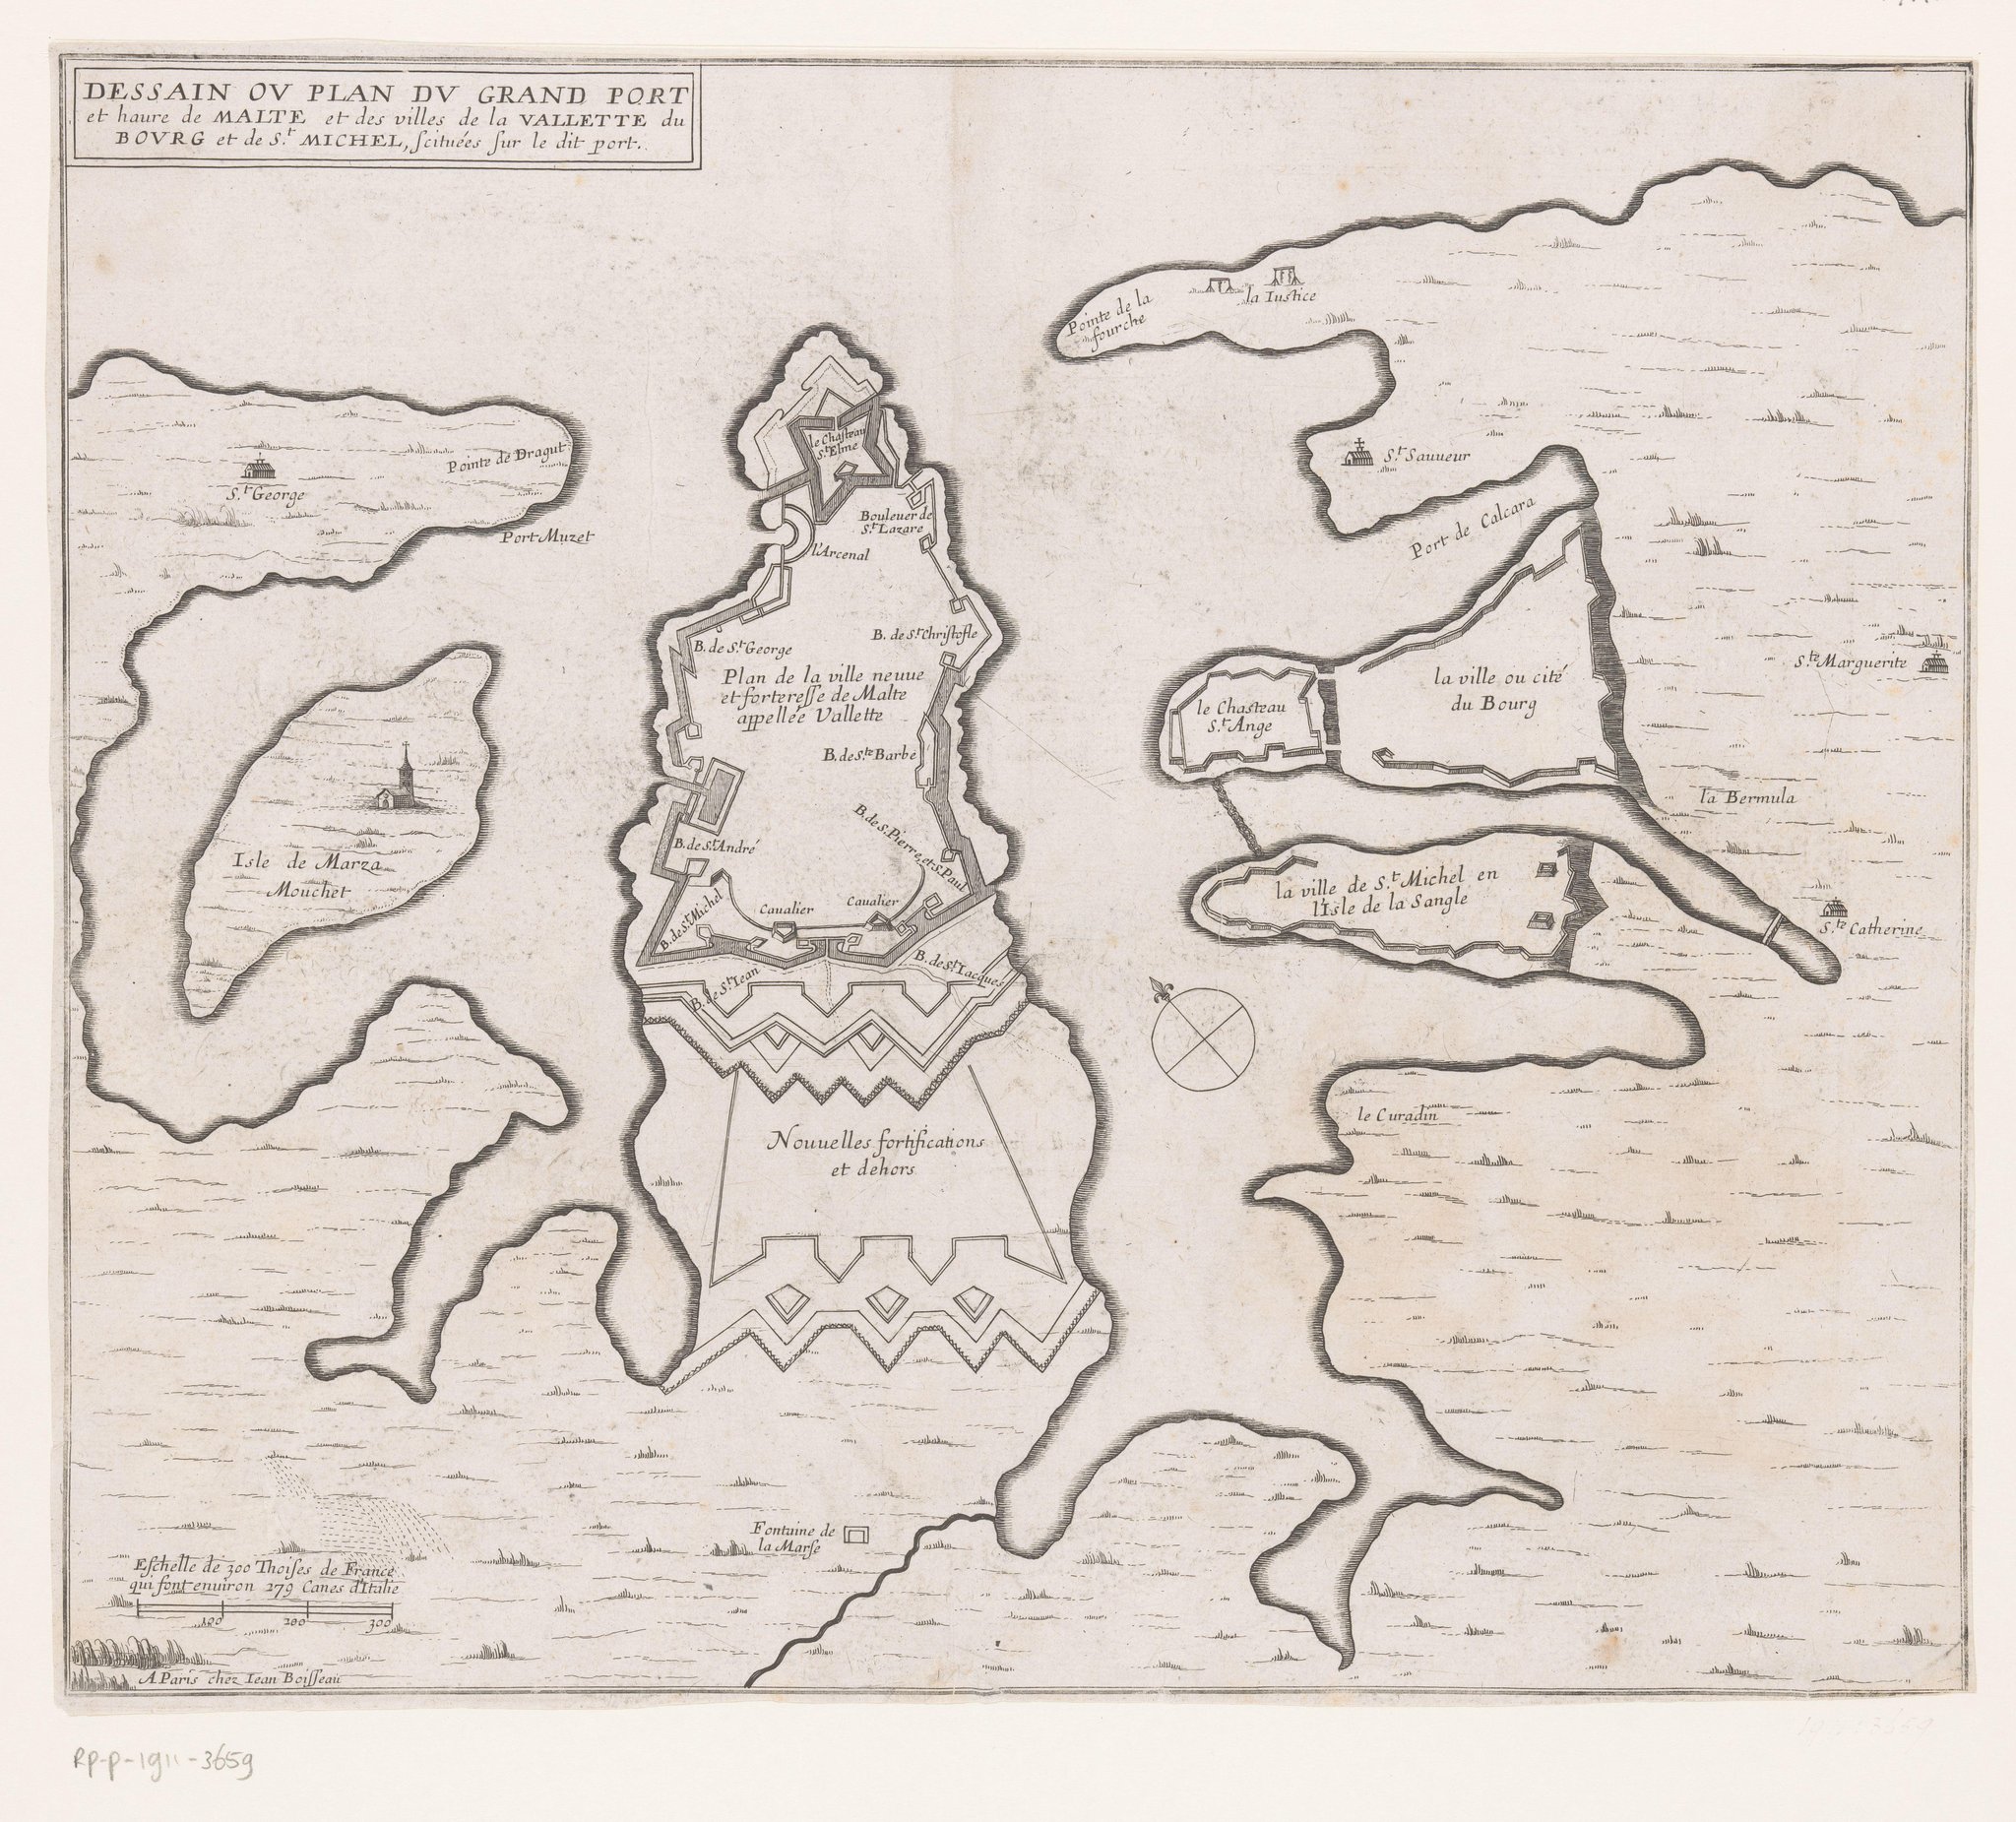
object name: print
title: Vestingplattegrond van de haven van Malta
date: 1631-1657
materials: paper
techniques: etching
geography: paris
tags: harbour, maps, atlases, fortified city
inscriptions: collector's mark: Lugt 2228